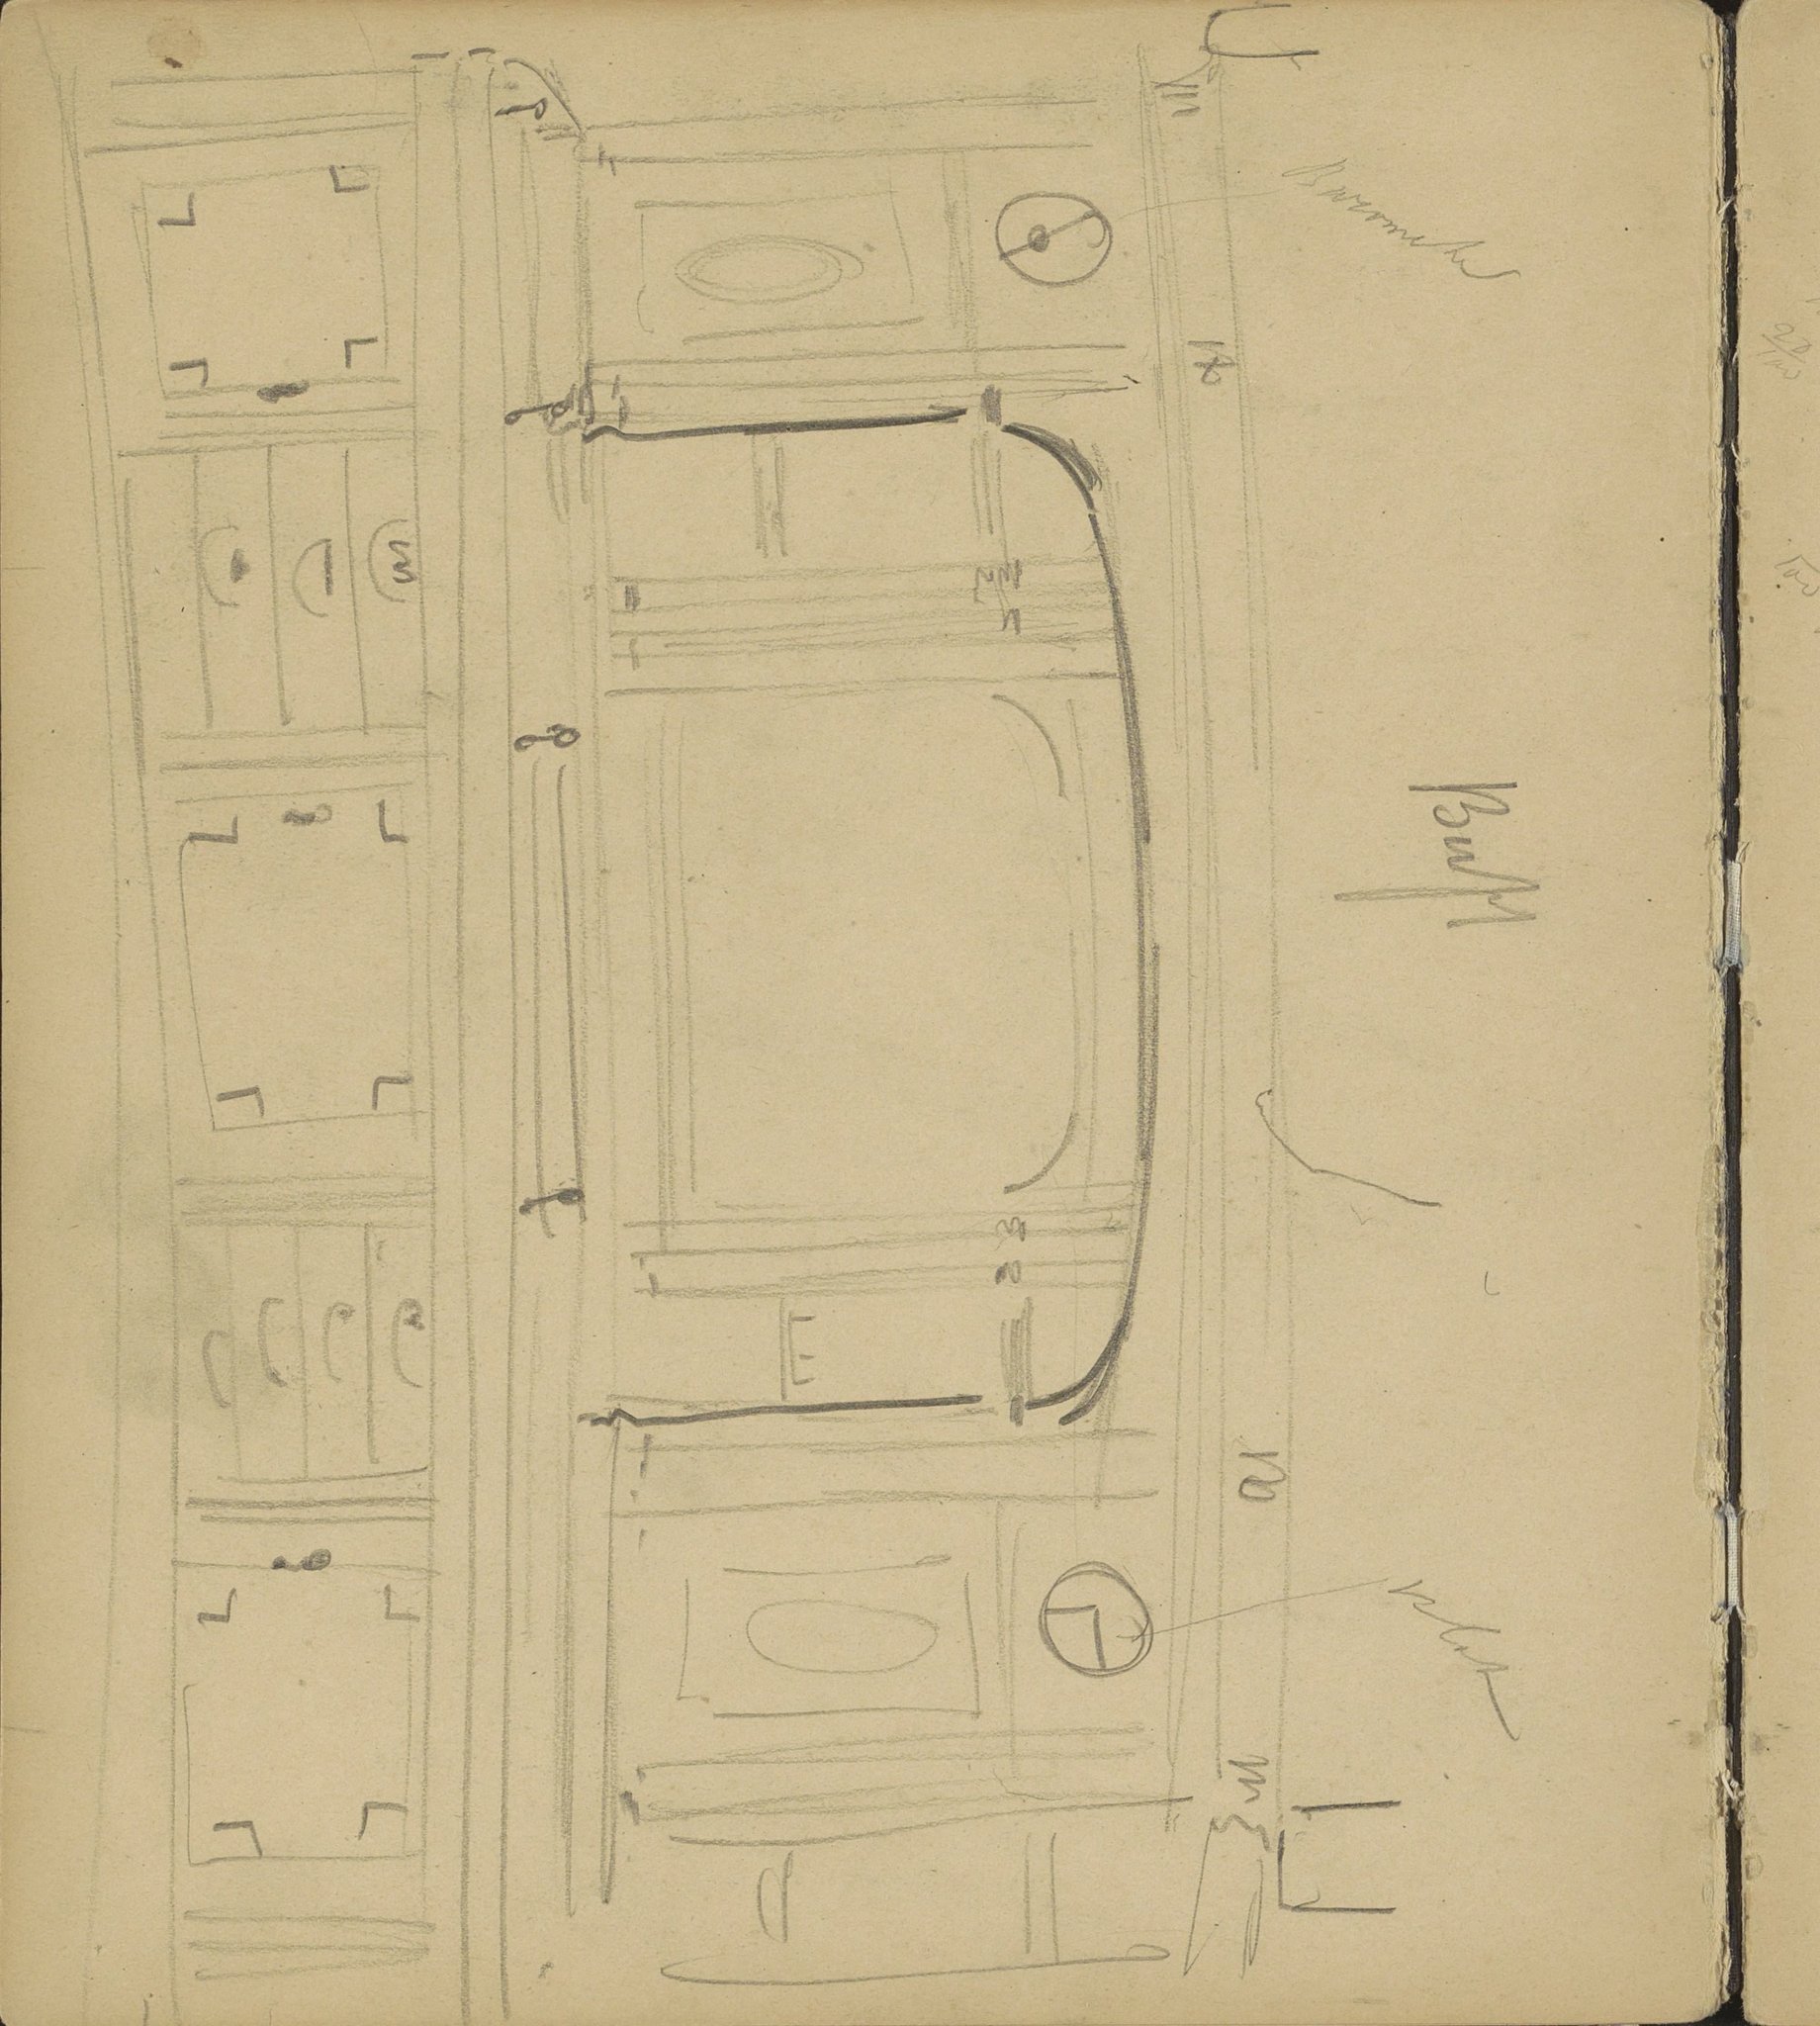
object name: sketchbook leaf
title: Ontwerp voor een buffetkast met een barometer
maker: carel adolph lion cachet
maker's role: draughtsman, print maker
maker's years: 1864-1945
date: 1906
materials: paper, pencil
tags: furniture for storage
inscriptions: annotation: ‘Buf[...]/ Barometer/ [...]lot’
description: Blad 3 verso uit een schetsboek met 27 bladen.